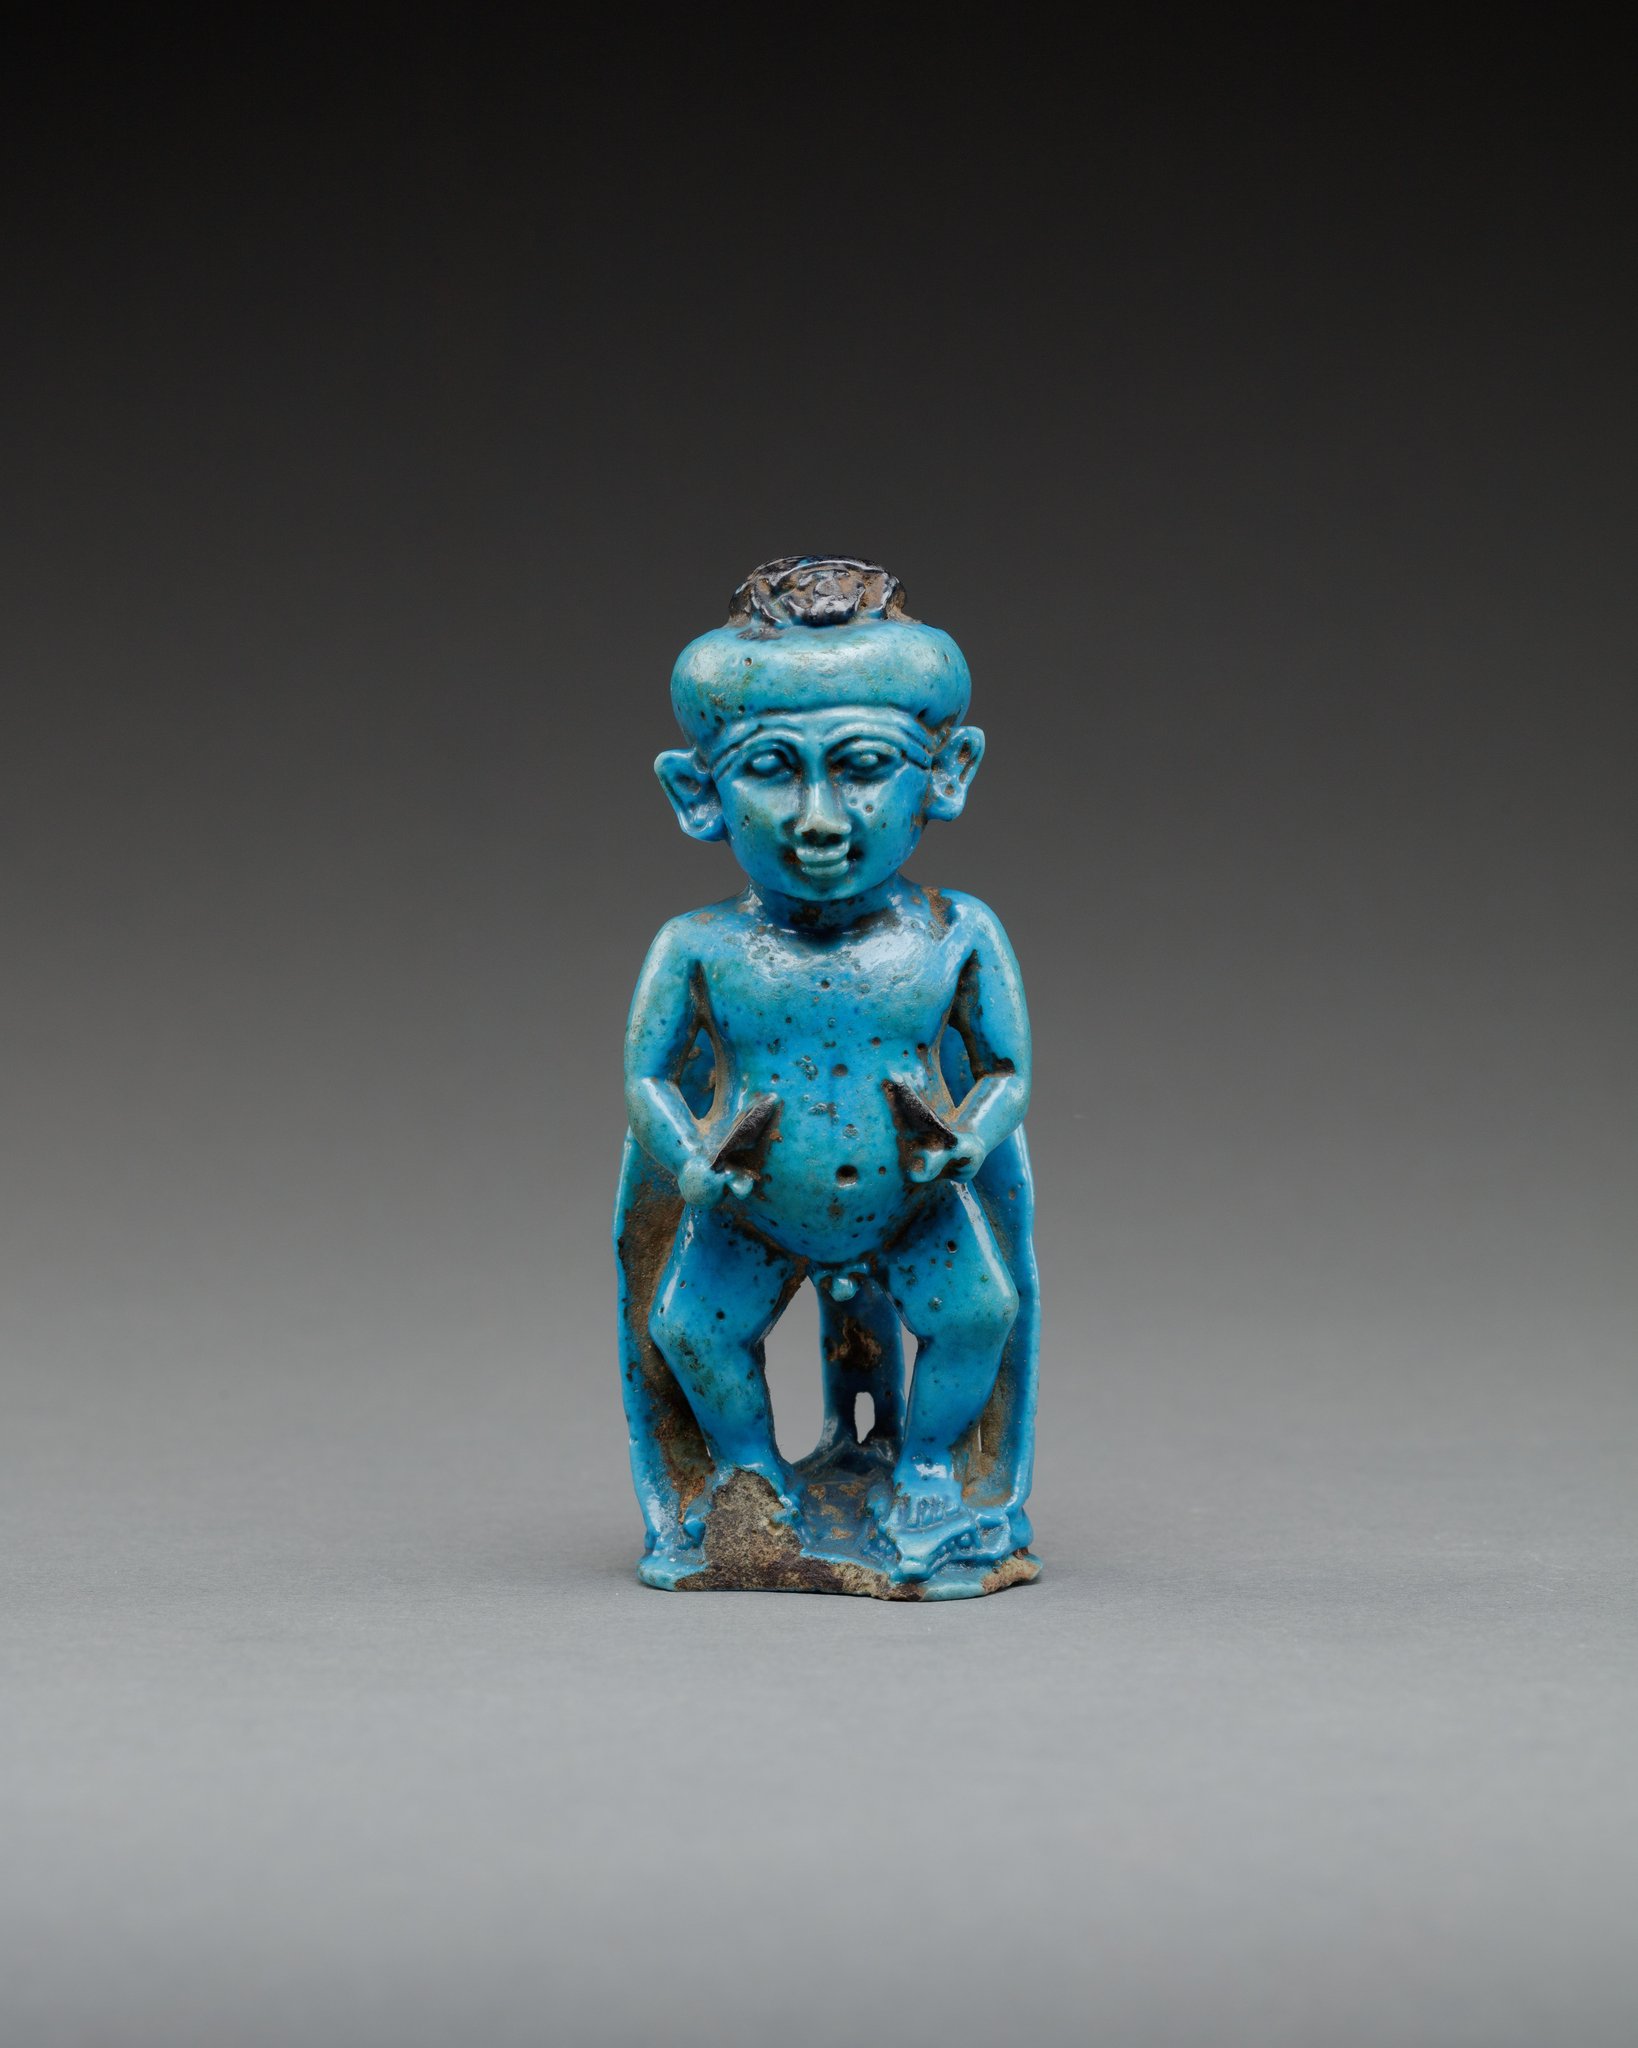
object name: amulet, pataikos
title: Pataikos Amulet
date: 1070-664 BCE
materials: faience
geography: egypt